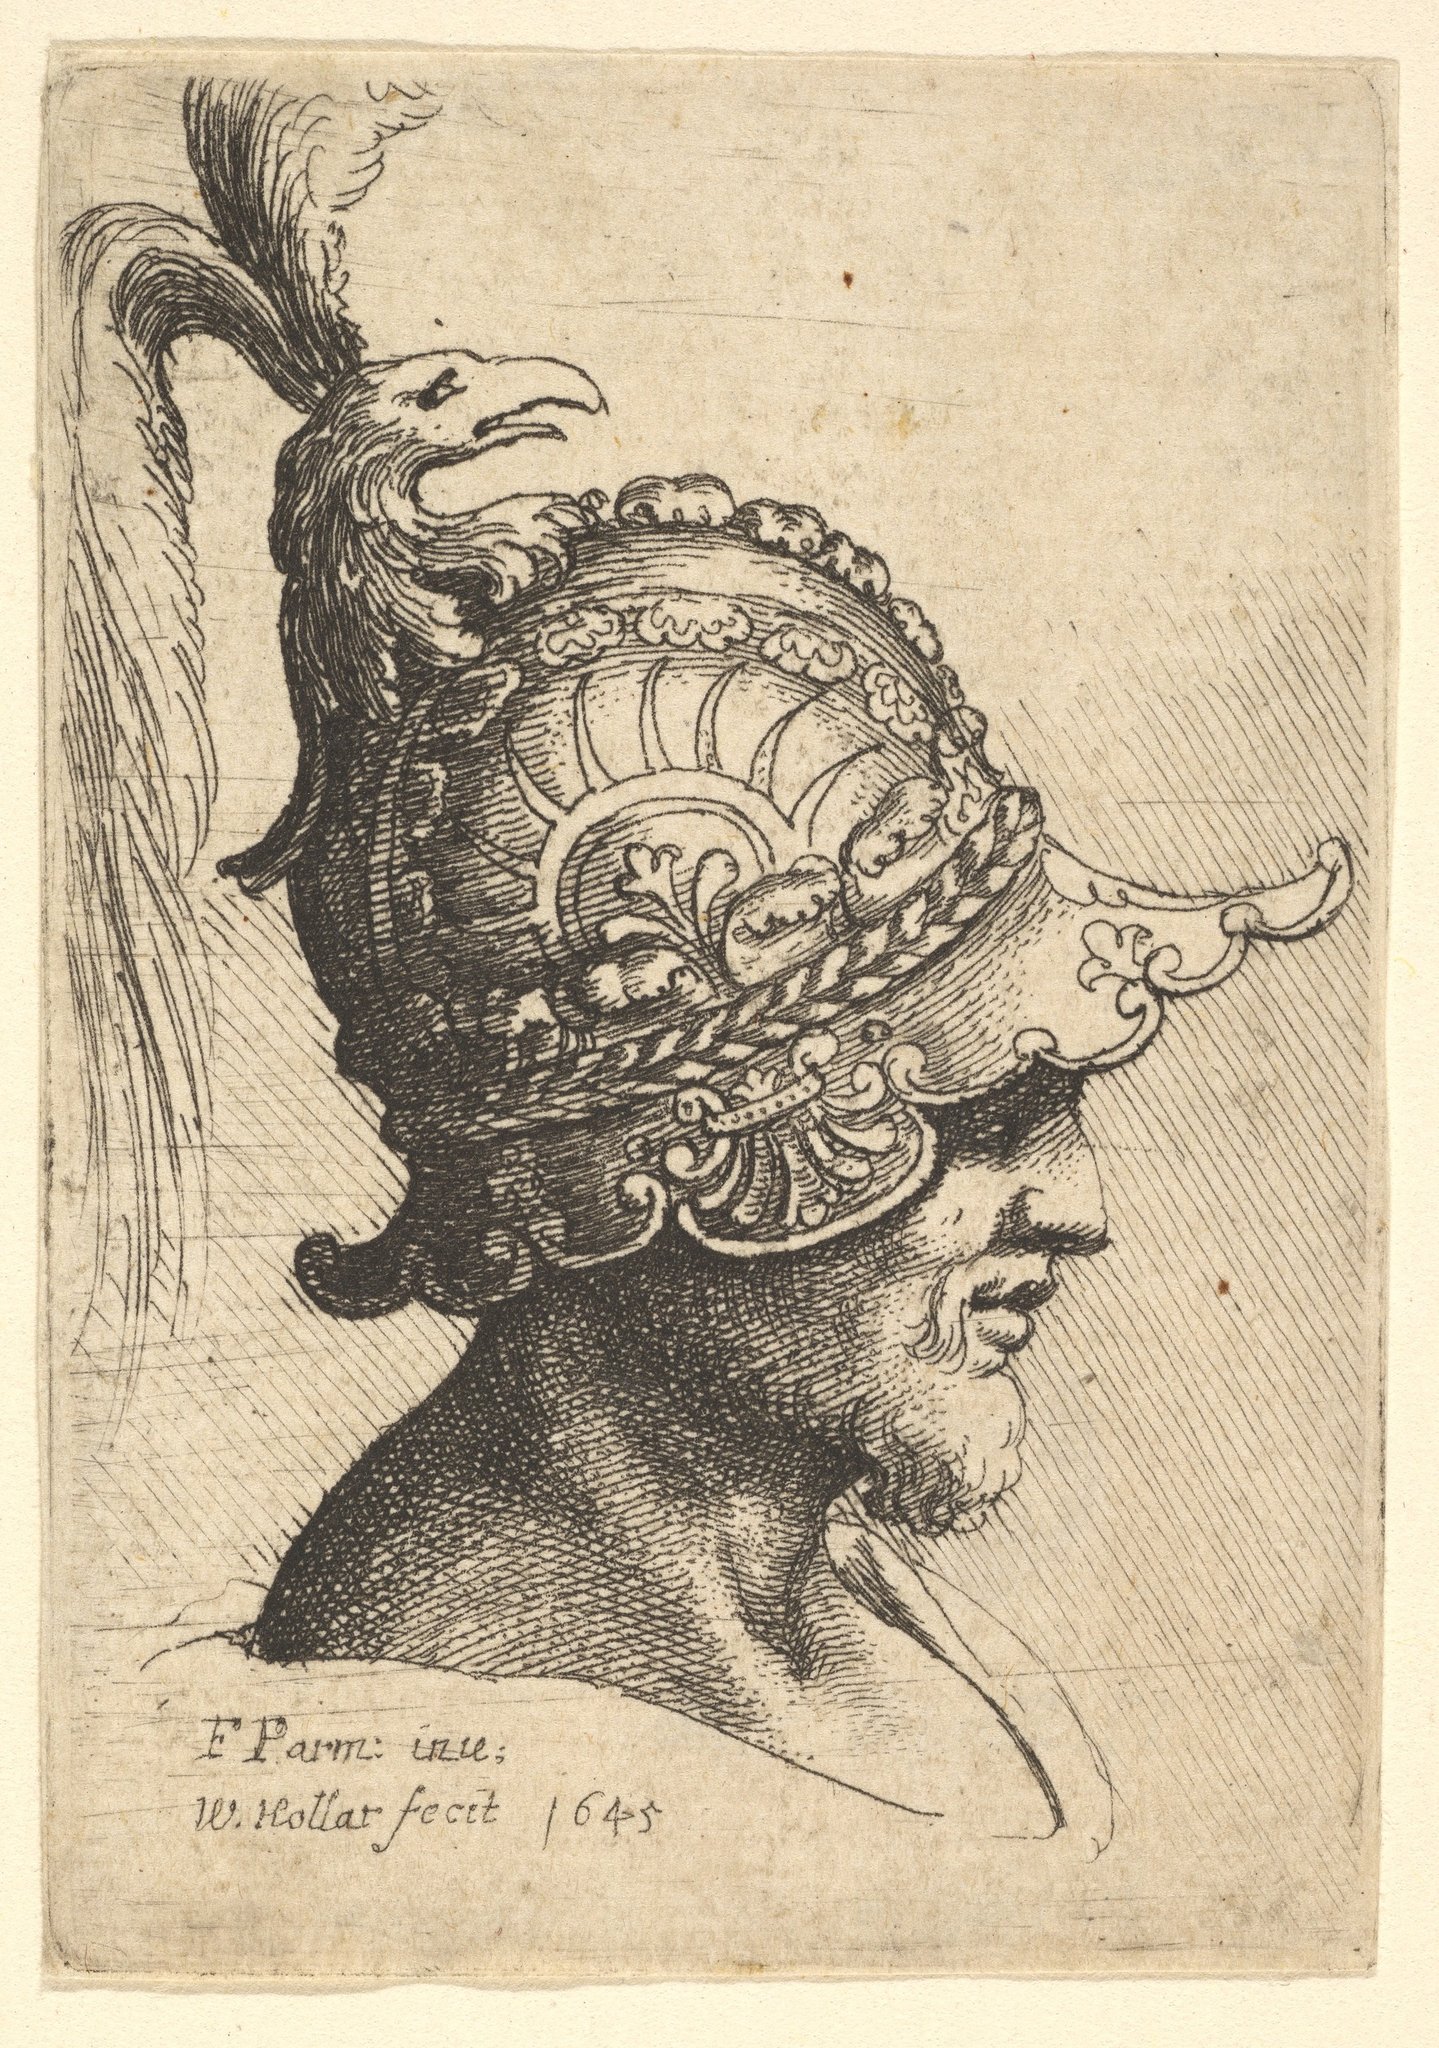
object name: print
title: Helmeted Head wtih Bird's Head Crest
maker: wenceslaus hollar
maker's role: artist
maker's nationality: bohemian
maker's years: 1607-1677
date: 1645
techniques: etching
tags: helmets,profiles,warriors